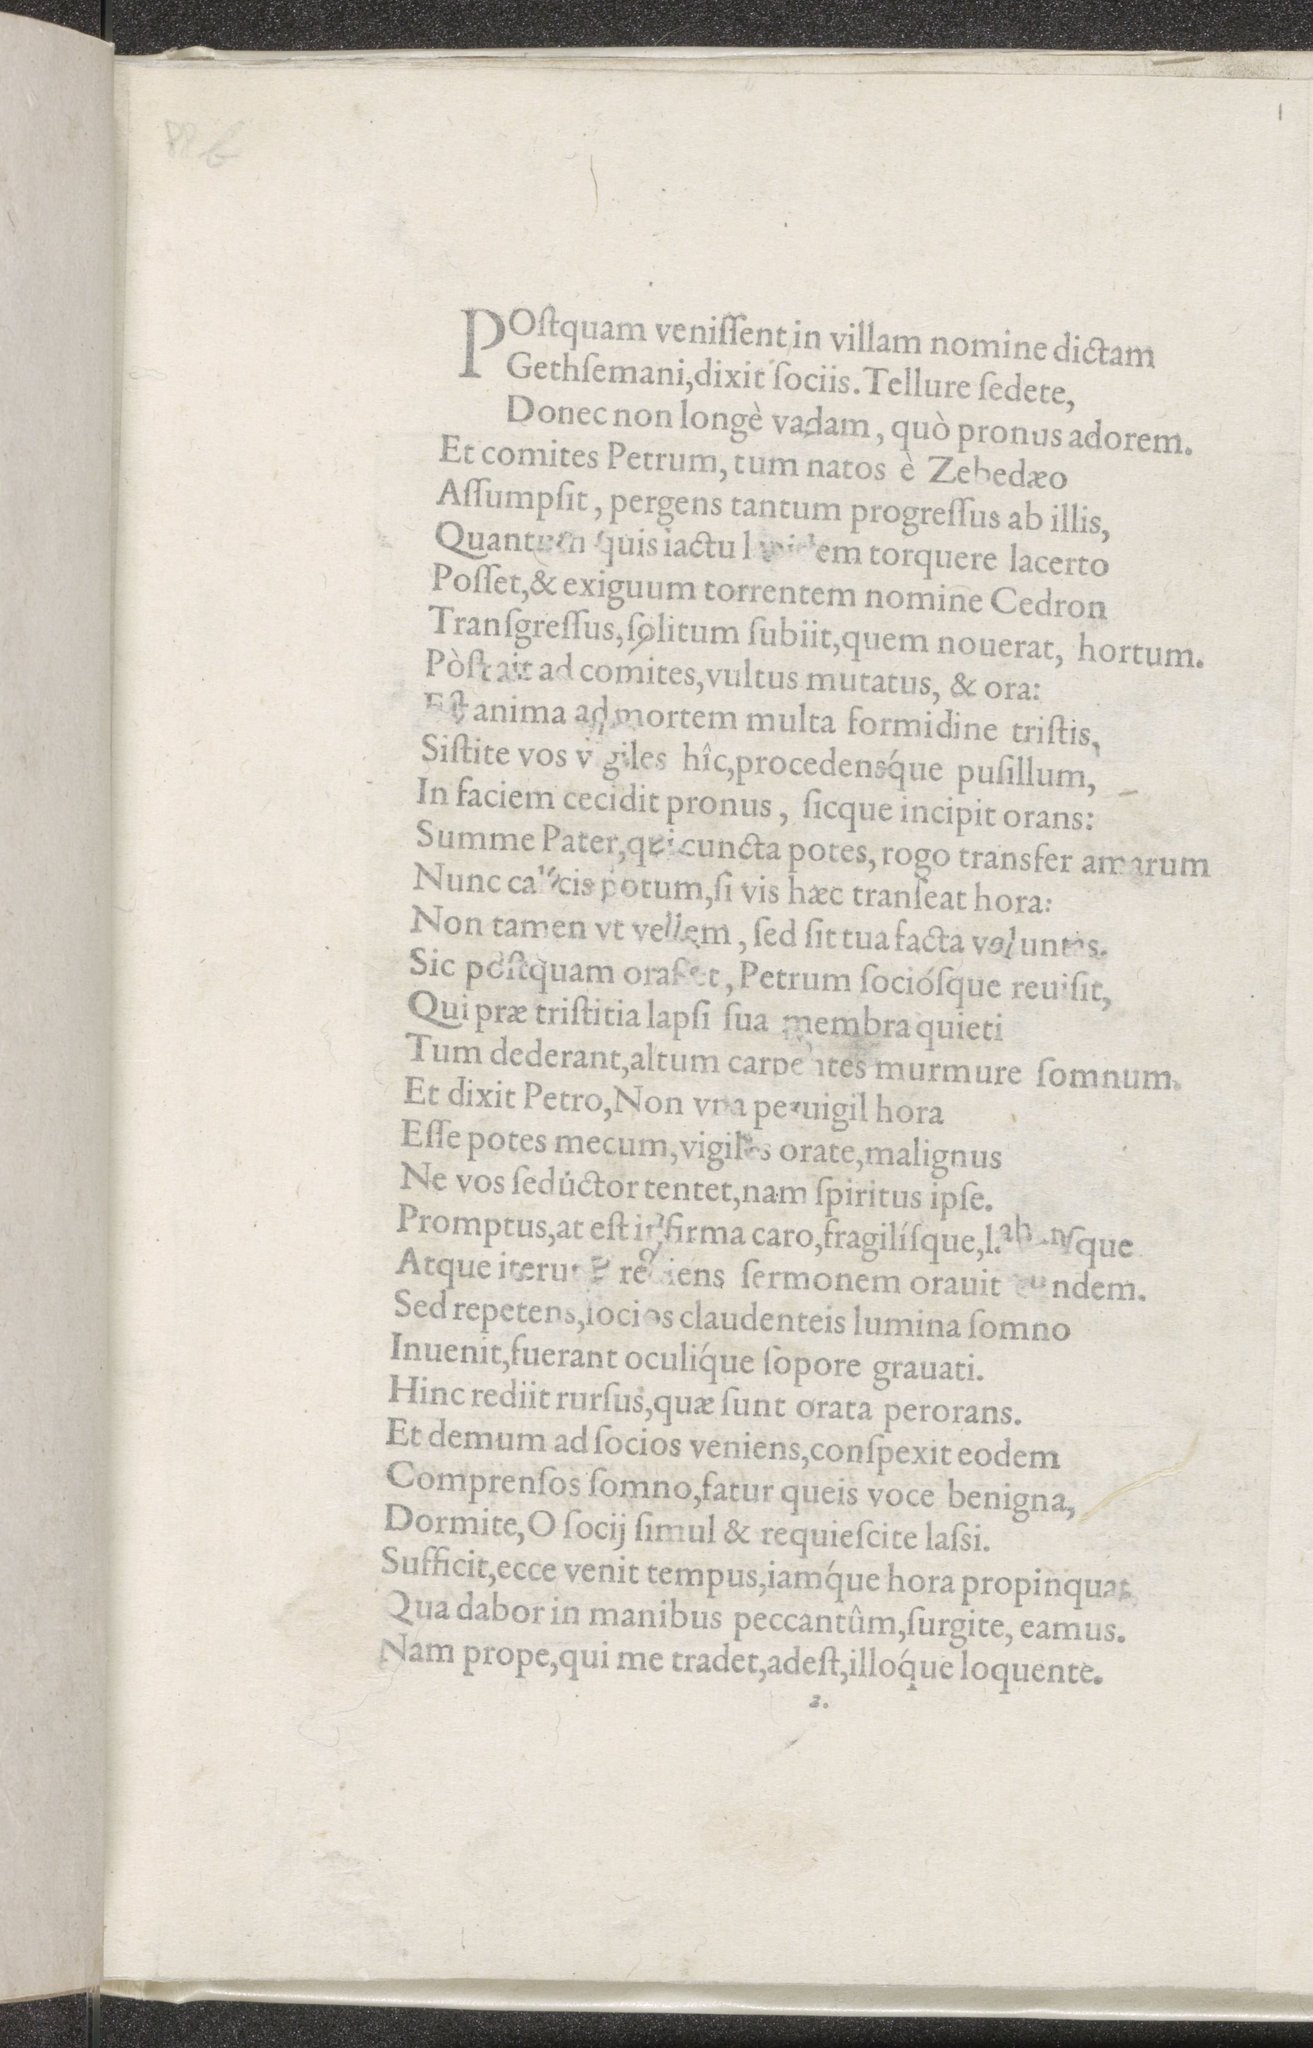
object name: text sheet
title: Tekst over Christus in de hof van Getsemane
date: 1572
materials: paper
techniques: letterpress printing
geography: antwerp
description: Tijdens de restauratie in 1988 bleek dat op de achterzijde van de prenten van de Passie-serie van Wierix Latijnse teksten in boekdruk staan. Deze vormen, wanneer op de juiste wijze in boekvorm gebonden (wat nu in het Heemskerck-album niet het geval is), een toelichting op de passievoorstellingen. Om de teksten zichtbaar te laten zijn de prenten bij de restauratie niet meer met de achterzijde op elkaar geplakt.